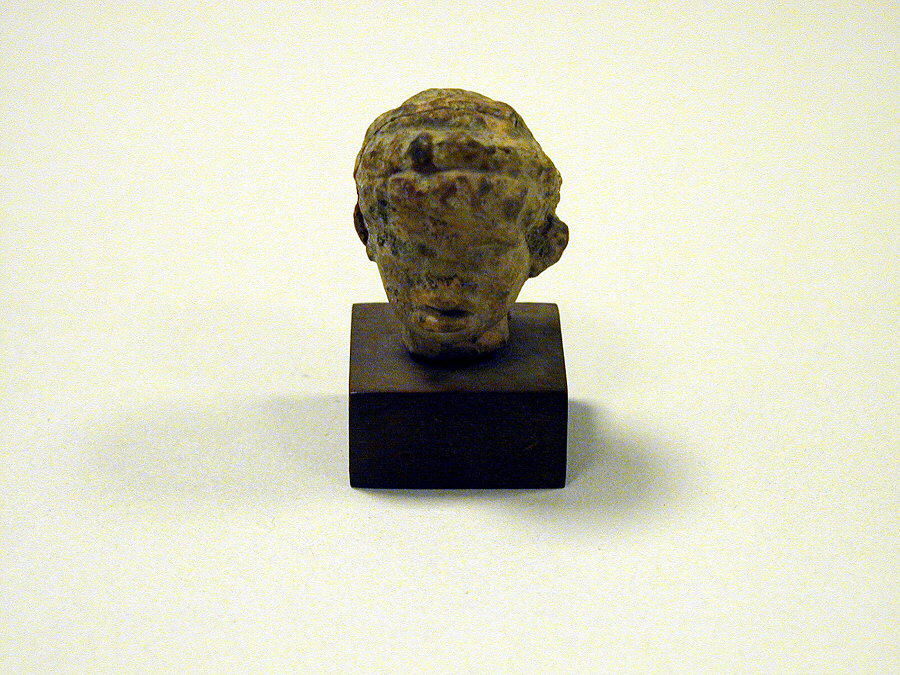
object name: head of a black boy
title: Head of a Black African youth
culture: greek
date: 7000-30 BCE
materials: terracotta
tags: heads,boys